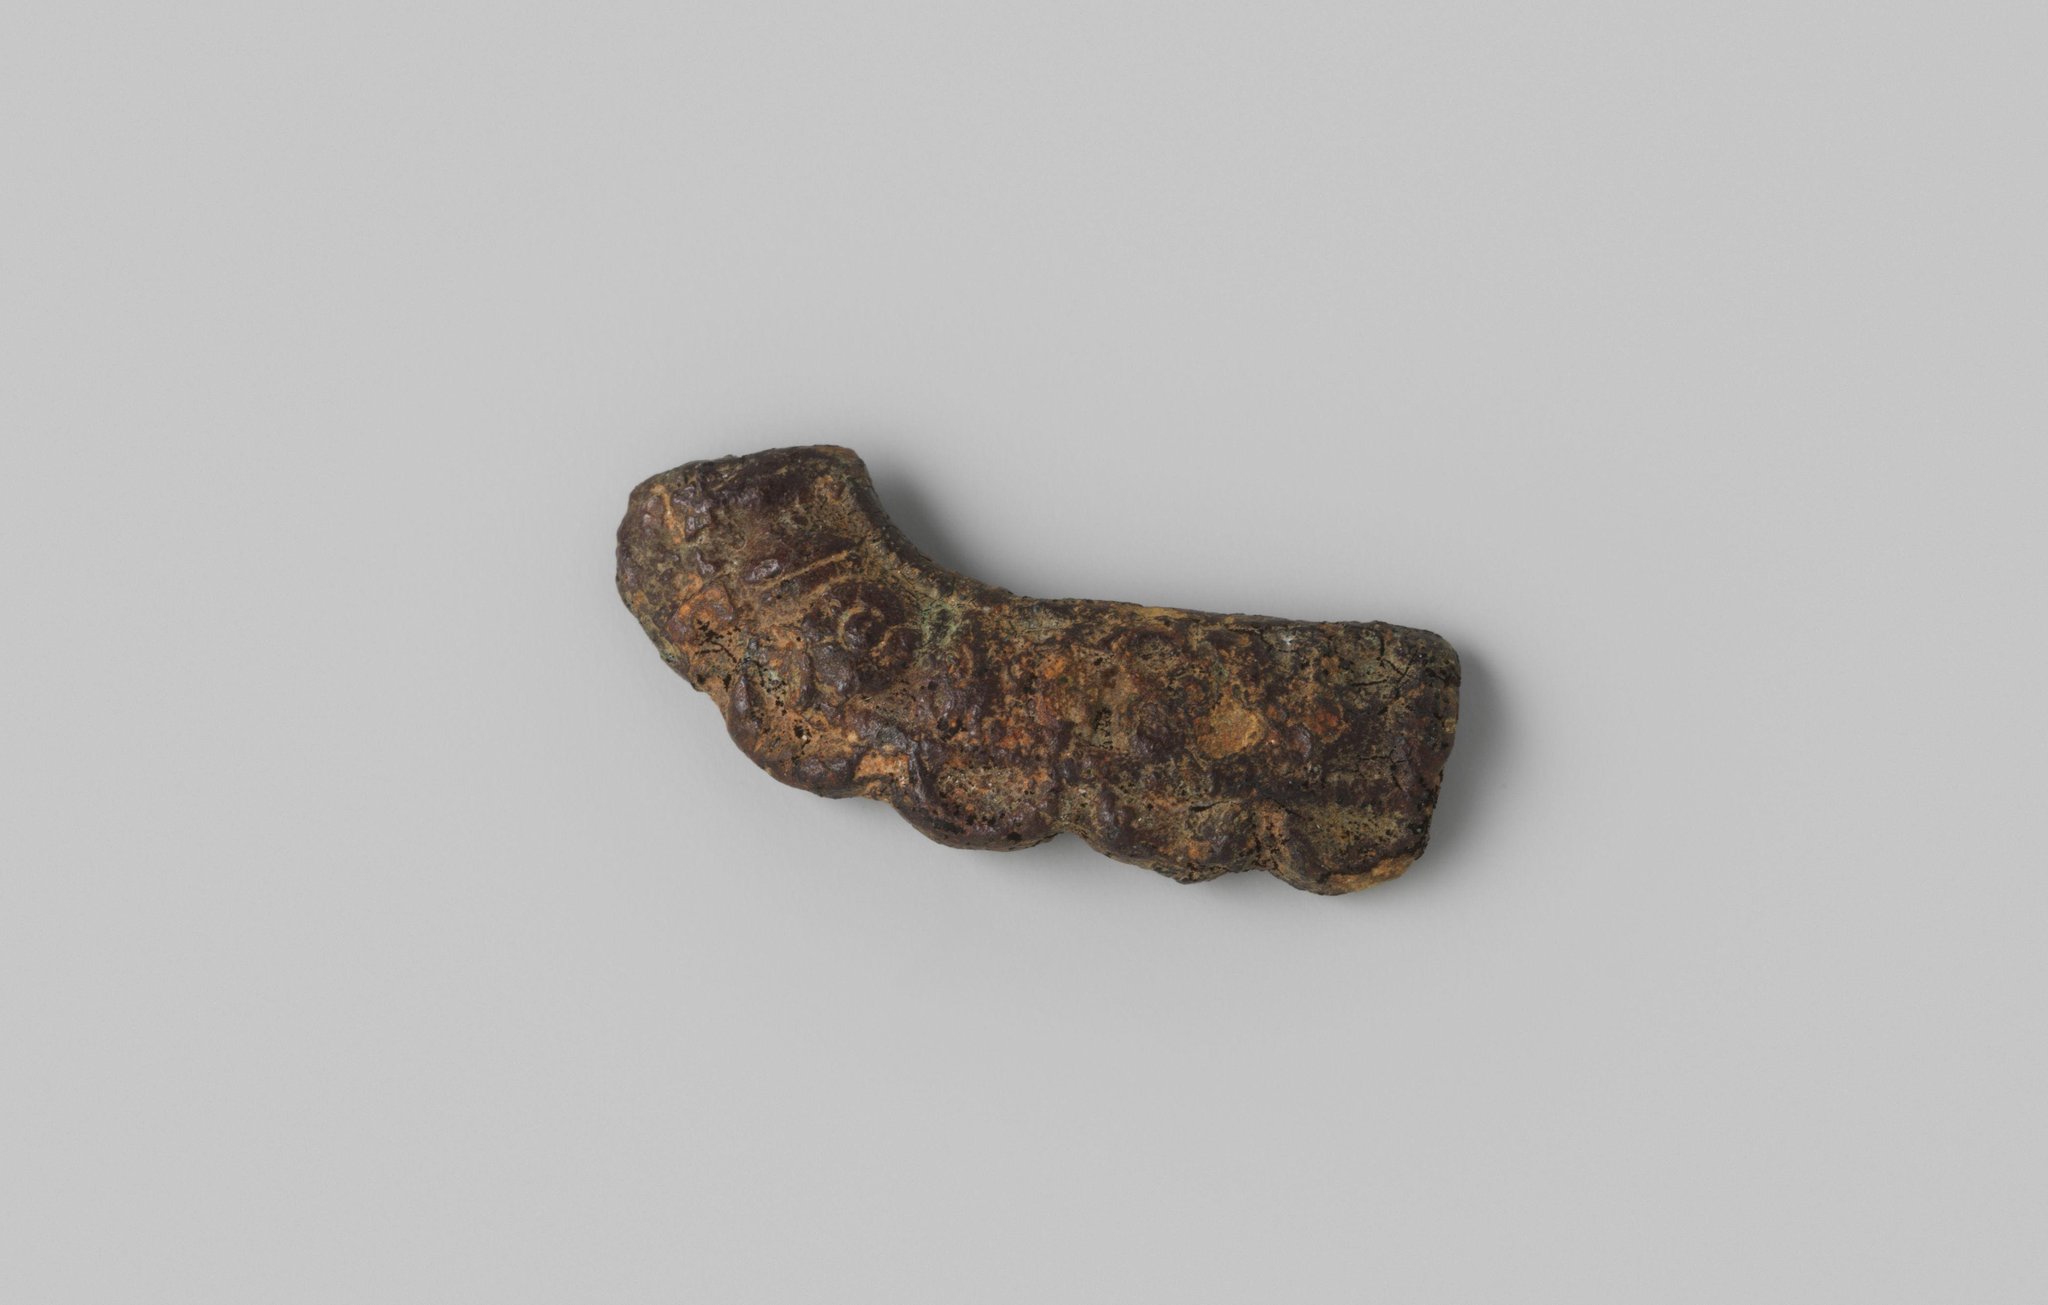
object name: buckle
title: Fragment van een gesp uit het wrak van de Oost-Indiëvaarder Hollandia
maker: Anonymous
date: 1700-1743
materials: copper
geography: netherlands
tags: verenigde oostindische compagnie, hollandia (schip), annet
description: Buckle, not identifiable; fragm of ring, curving corner, lobed rim.